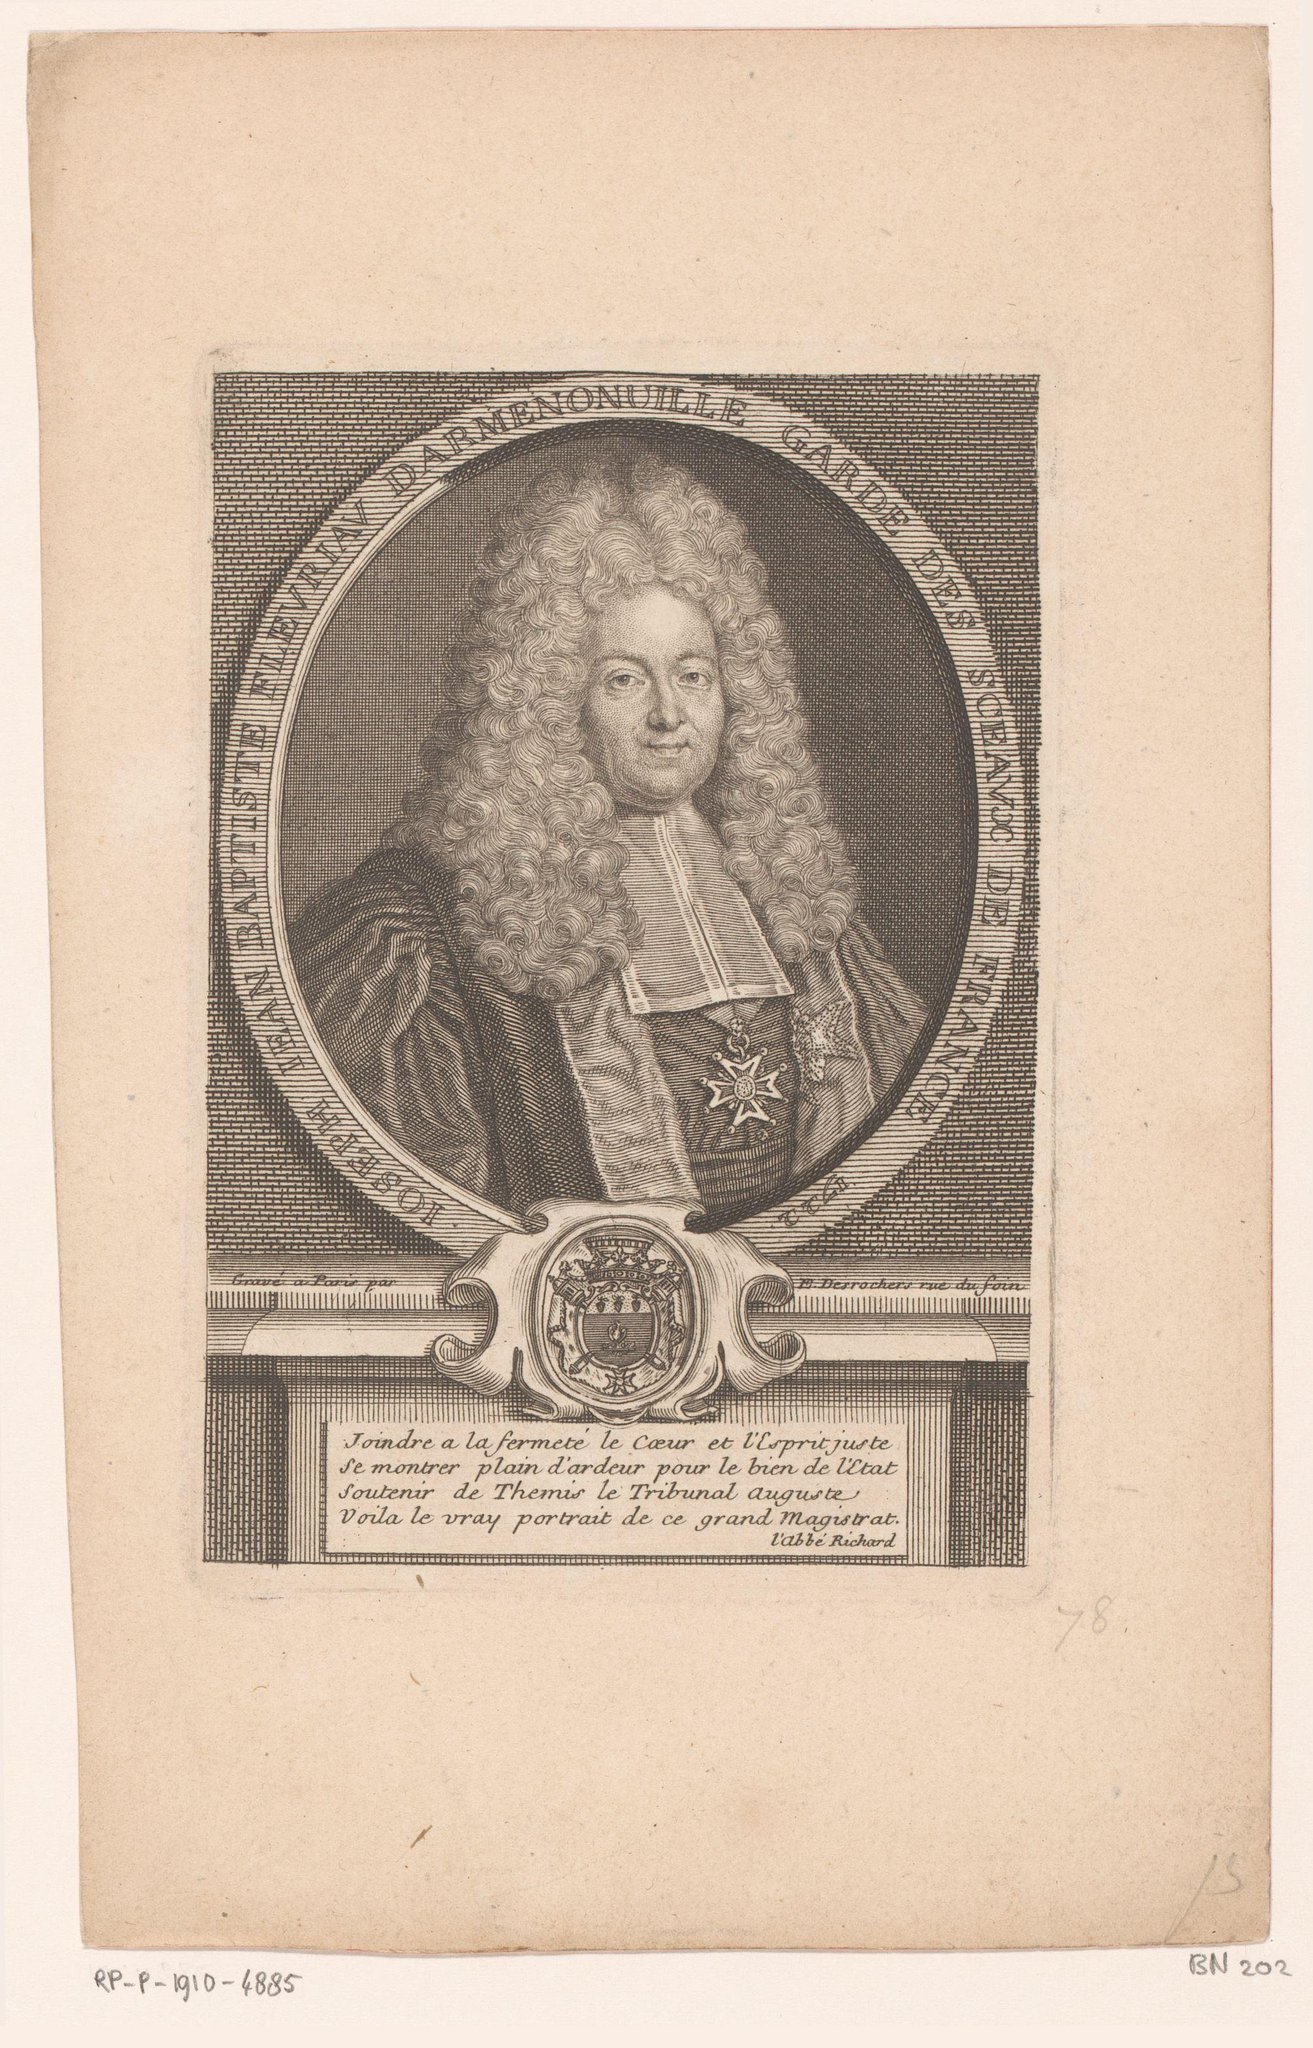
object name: print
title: Verzameling portretten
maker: étienne desrochers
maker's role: print maker, publisher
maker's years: 1668-1741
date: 1726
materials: paper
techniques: engraving, etching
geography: paris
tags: paris, politician, historical persons, politician, e.g. party leader, armorial bearing, heraldry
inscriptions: collector's mark: Lugt 2228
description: Behoort waarschijnlijk tot een serie portretten, grotendeels door Etienne Desrochers, getiteld: 'Recueil de portraits de personnes qui se sont distinguées tant dans les Armes que dans Belles-Lettres et les Arts, comme aussi la famille royale de France et autres cours étrangères'. De serie werd initieel uitgegeven door Desrochers en aangekondigd in 'Mercure' in mei 1726, p. 985. Echter was Desrochers reeds enkele jaren eerder begonnen met het uitgeven van de serie. Na de dood van Desrochers werd de serie voortgezet door Gilles Edme Petit. Een latere staat werd uitgegeven door Jean François Daumont in Parijs.